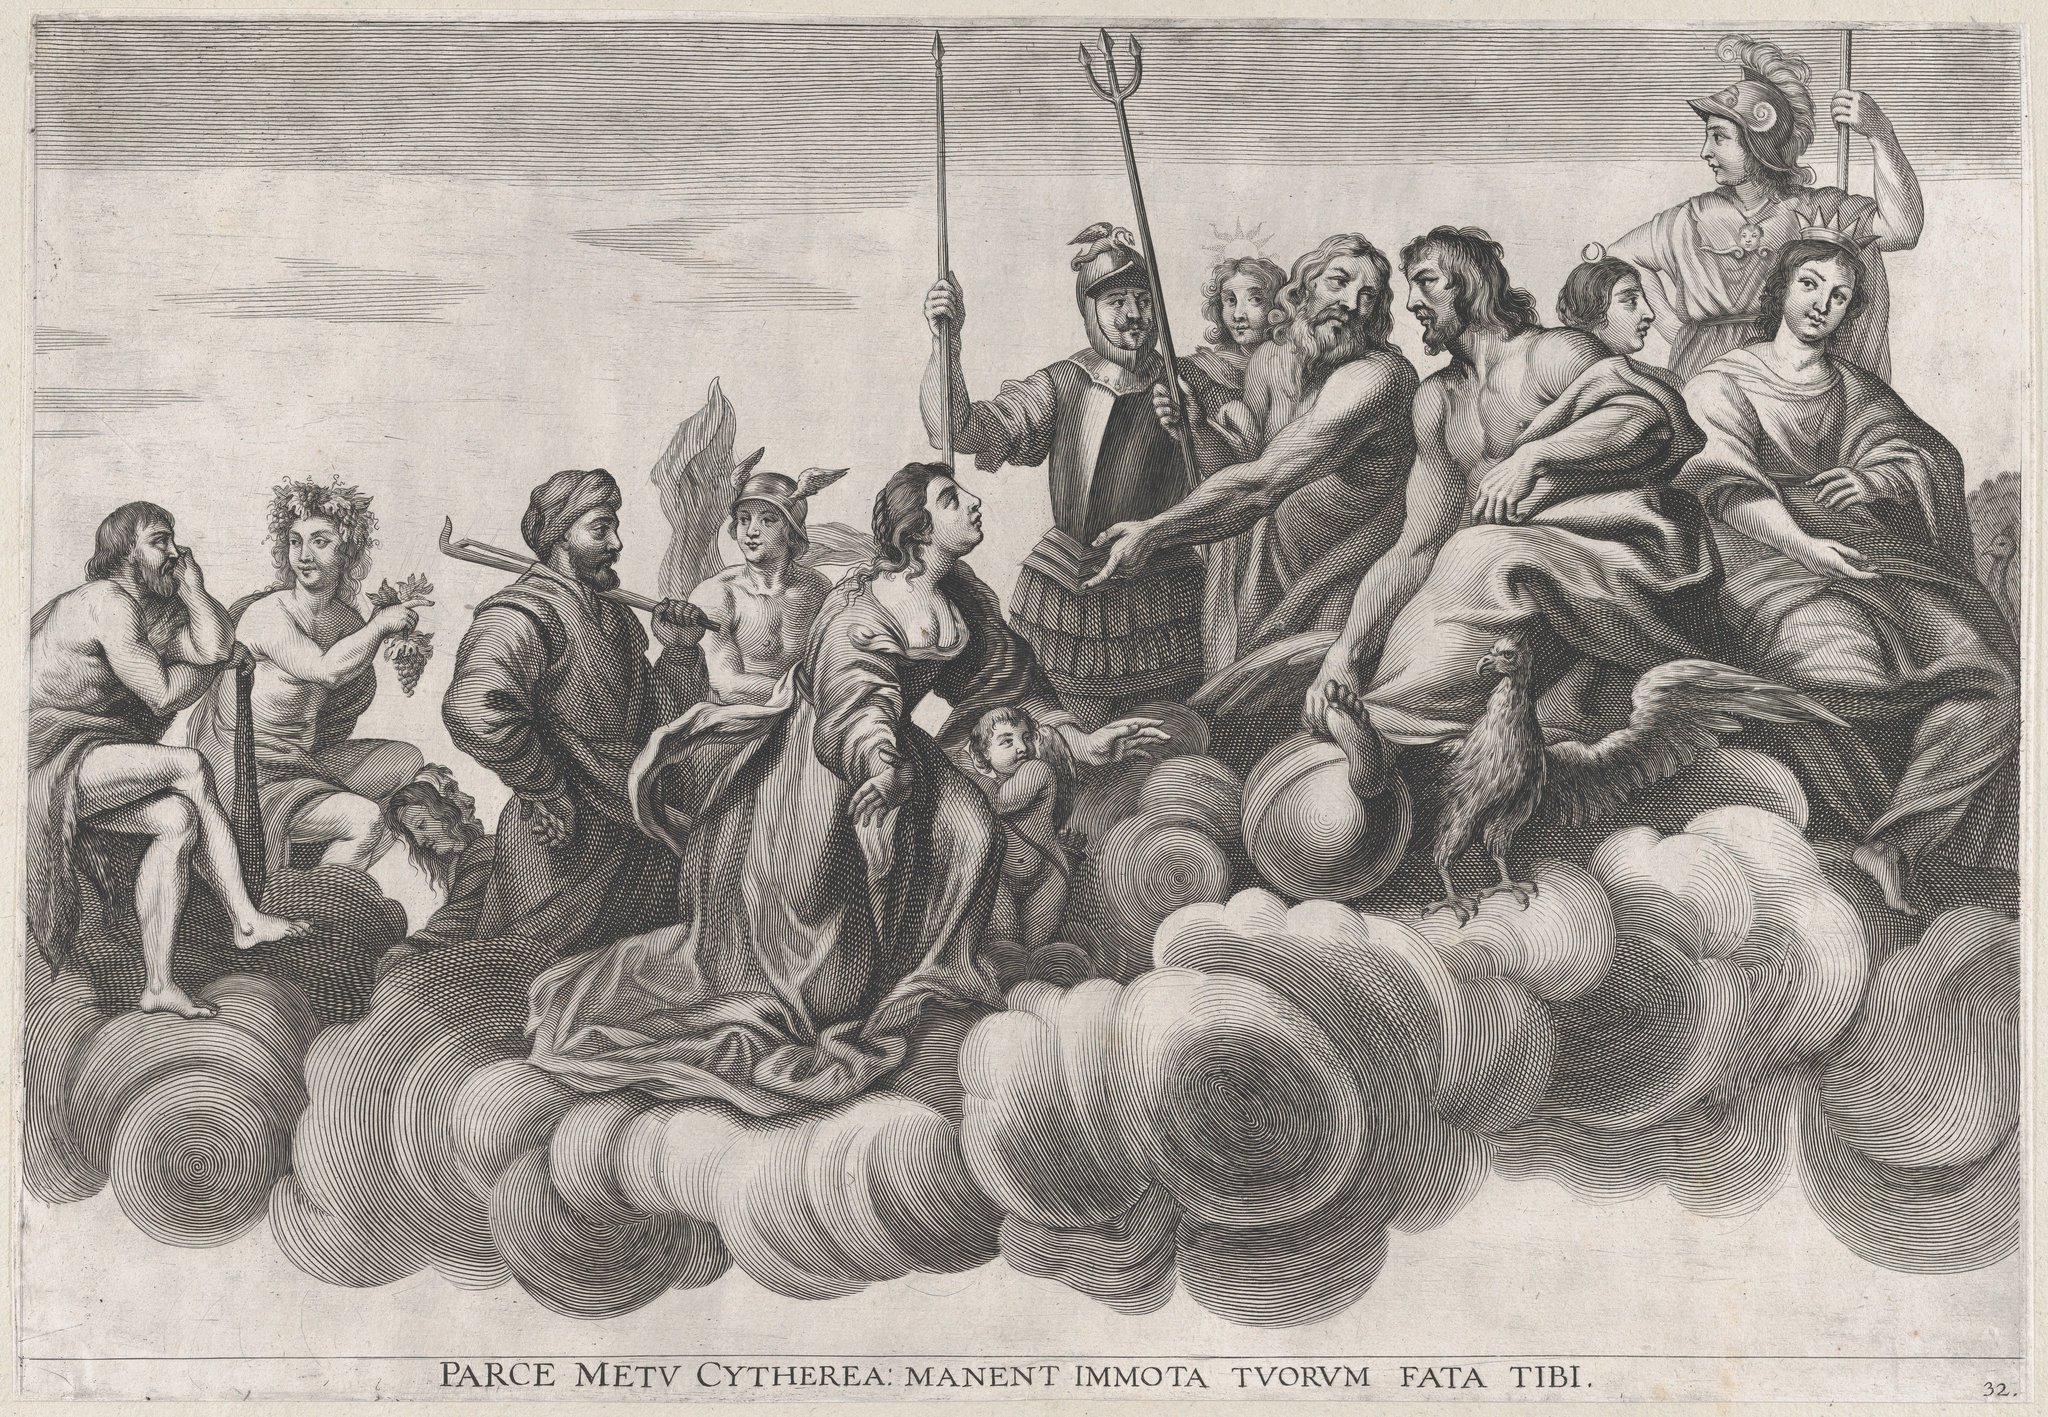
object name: print, fete, ornament architecture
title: Plate 32: Venus asking Jupiter for protection; from Guillielmus Becanus's 'Serenissimi Principis Ferdinandi, Hispaniarum Infantis...'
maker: johannes meursius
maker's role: publisher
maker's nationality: flemish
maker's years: 1600-1699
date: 1636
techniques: engraving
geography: antwerp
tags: children,men,women,jupiter,venus